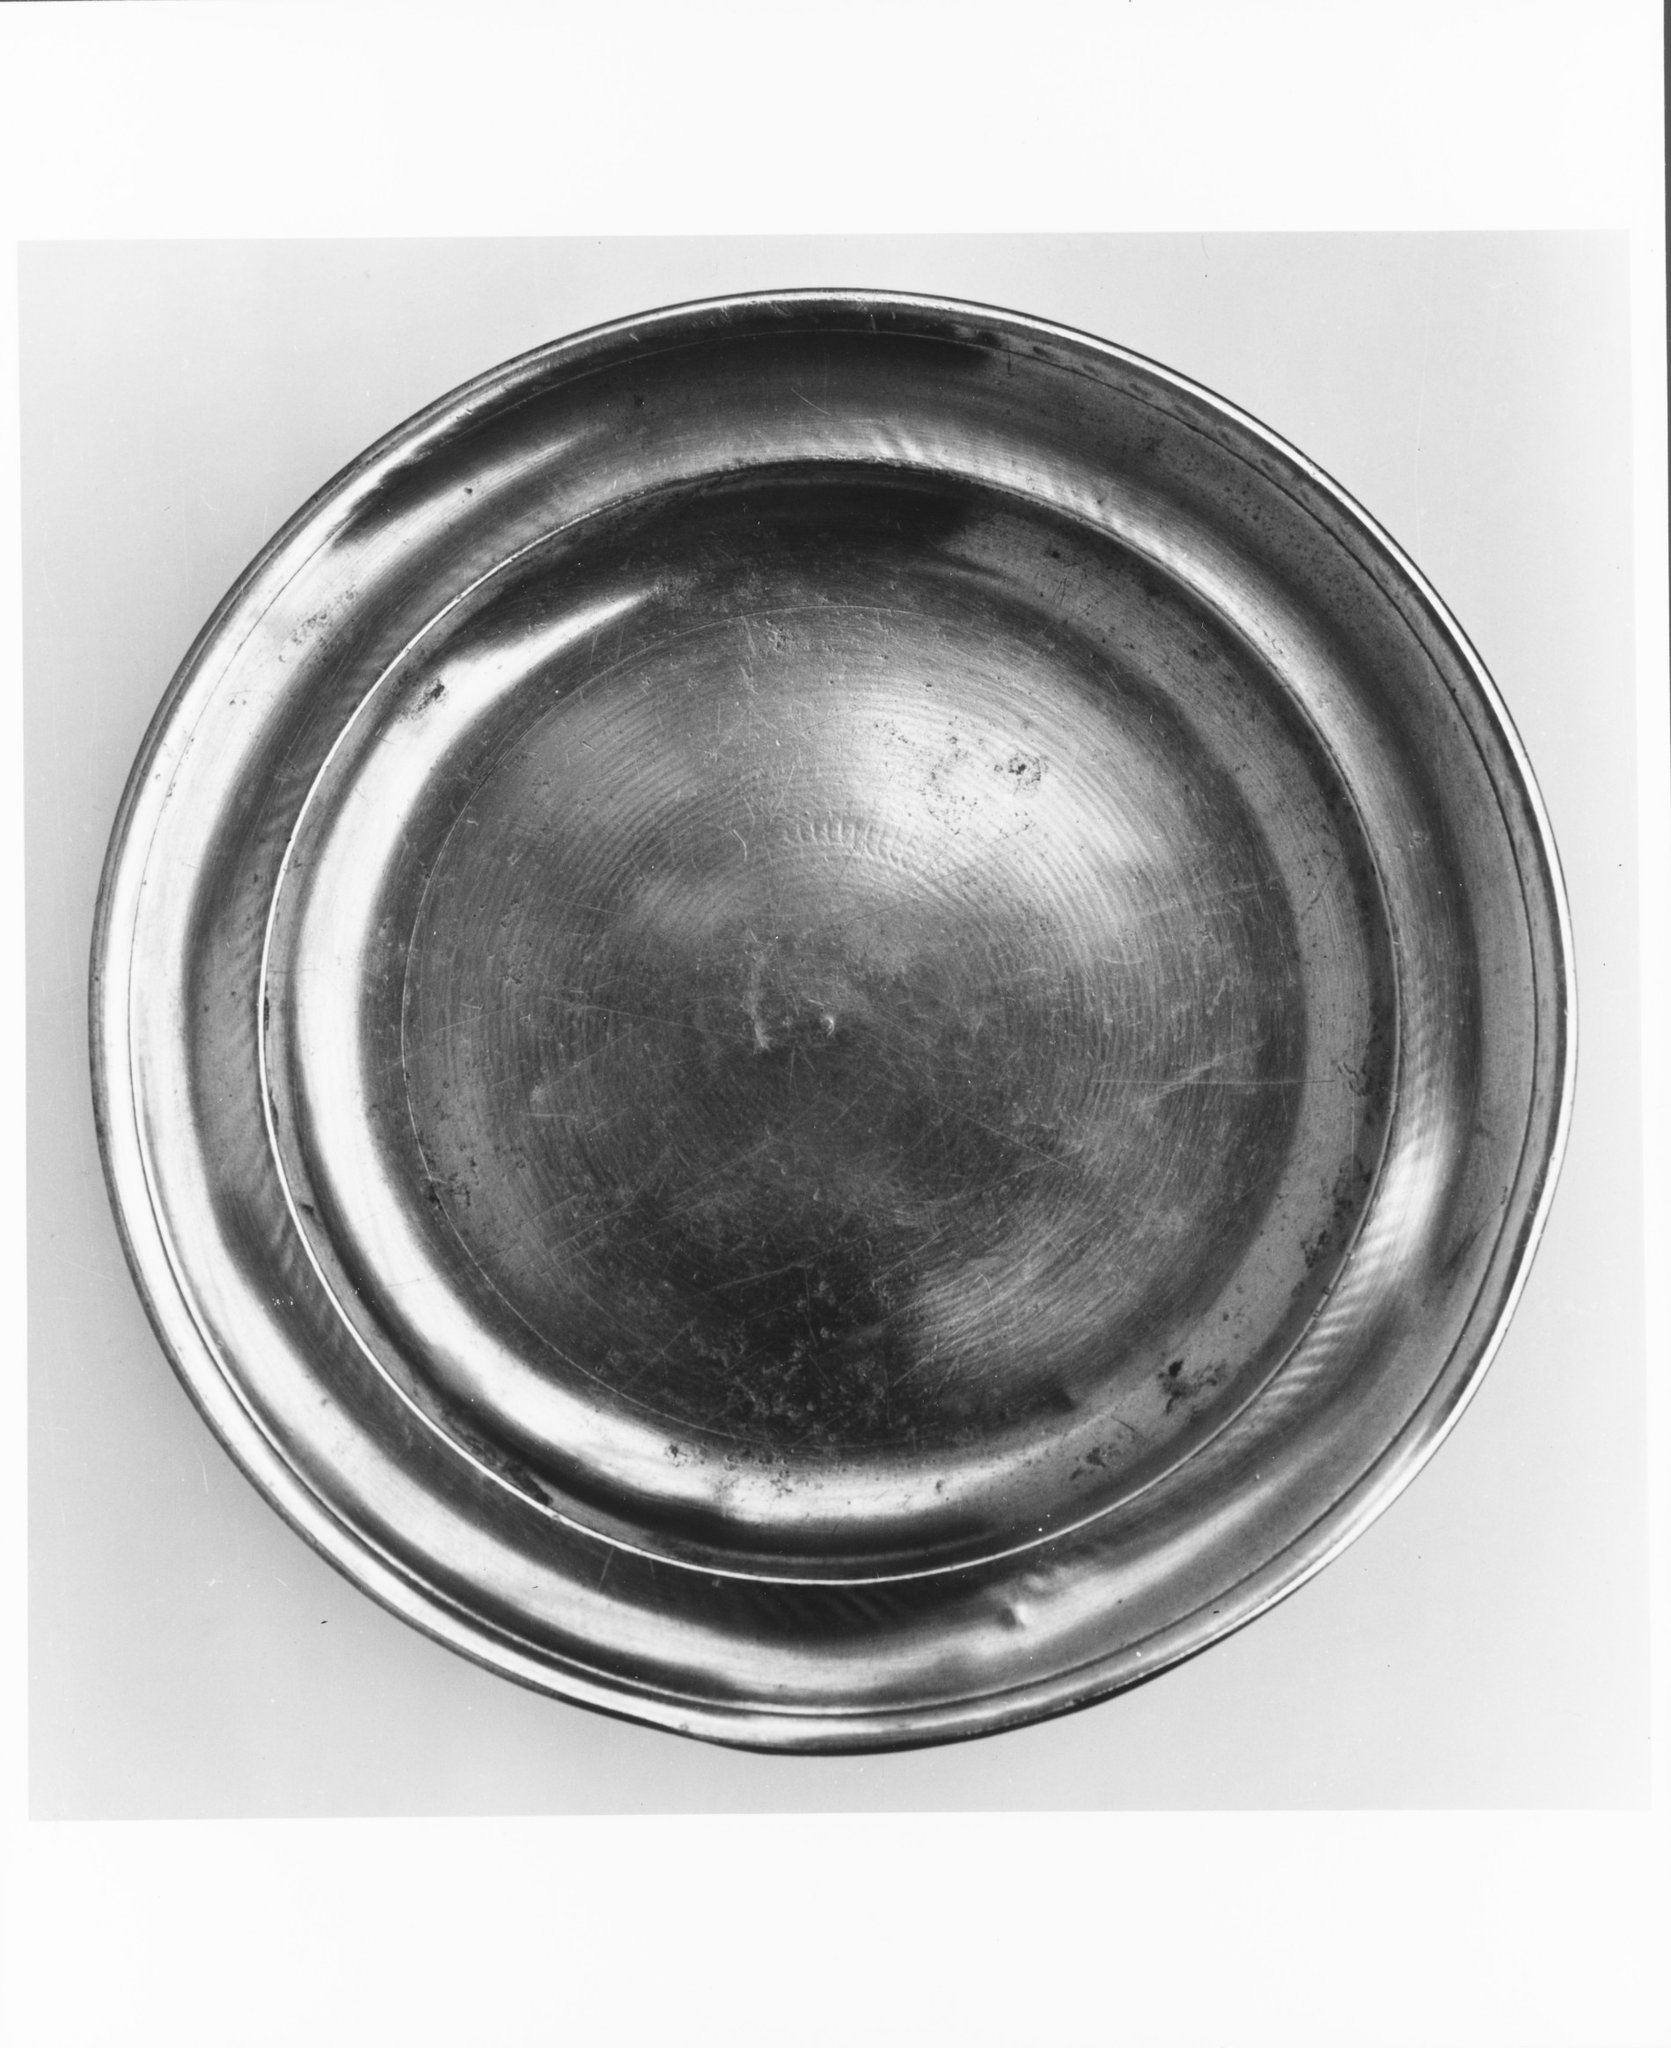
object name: plate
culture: american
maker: william billings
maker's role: maker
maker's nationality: american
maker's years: 1765-1813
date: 1791-1806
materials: pewter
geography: united states